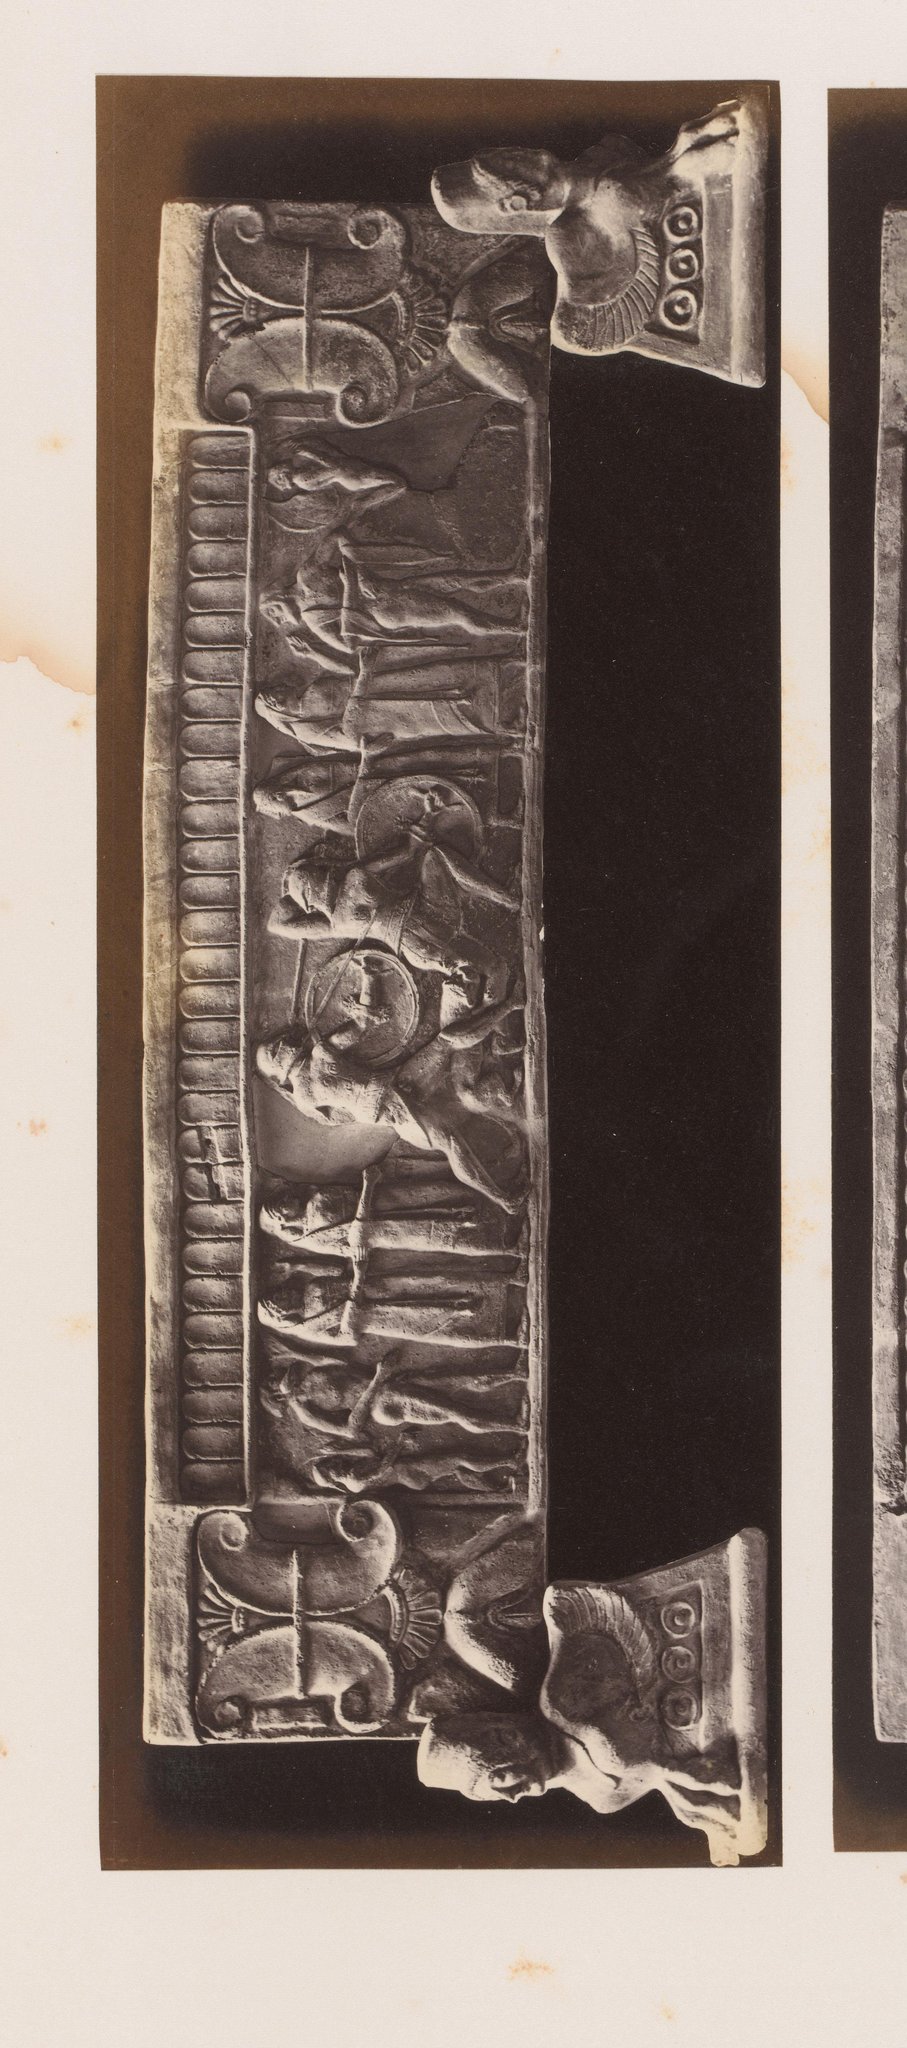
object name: page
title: Twee zijden van een Etruskische sarcofaag van terracotta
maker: stephen thompson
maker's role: fotograaf, schrijver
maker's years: 1831-1893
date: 1869-1874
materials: photographic support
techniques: albumen print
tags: sarcophagus, harpy (fabulous bird); 'arpie' (ripa), sculpture (+ relief ~ sculpture)